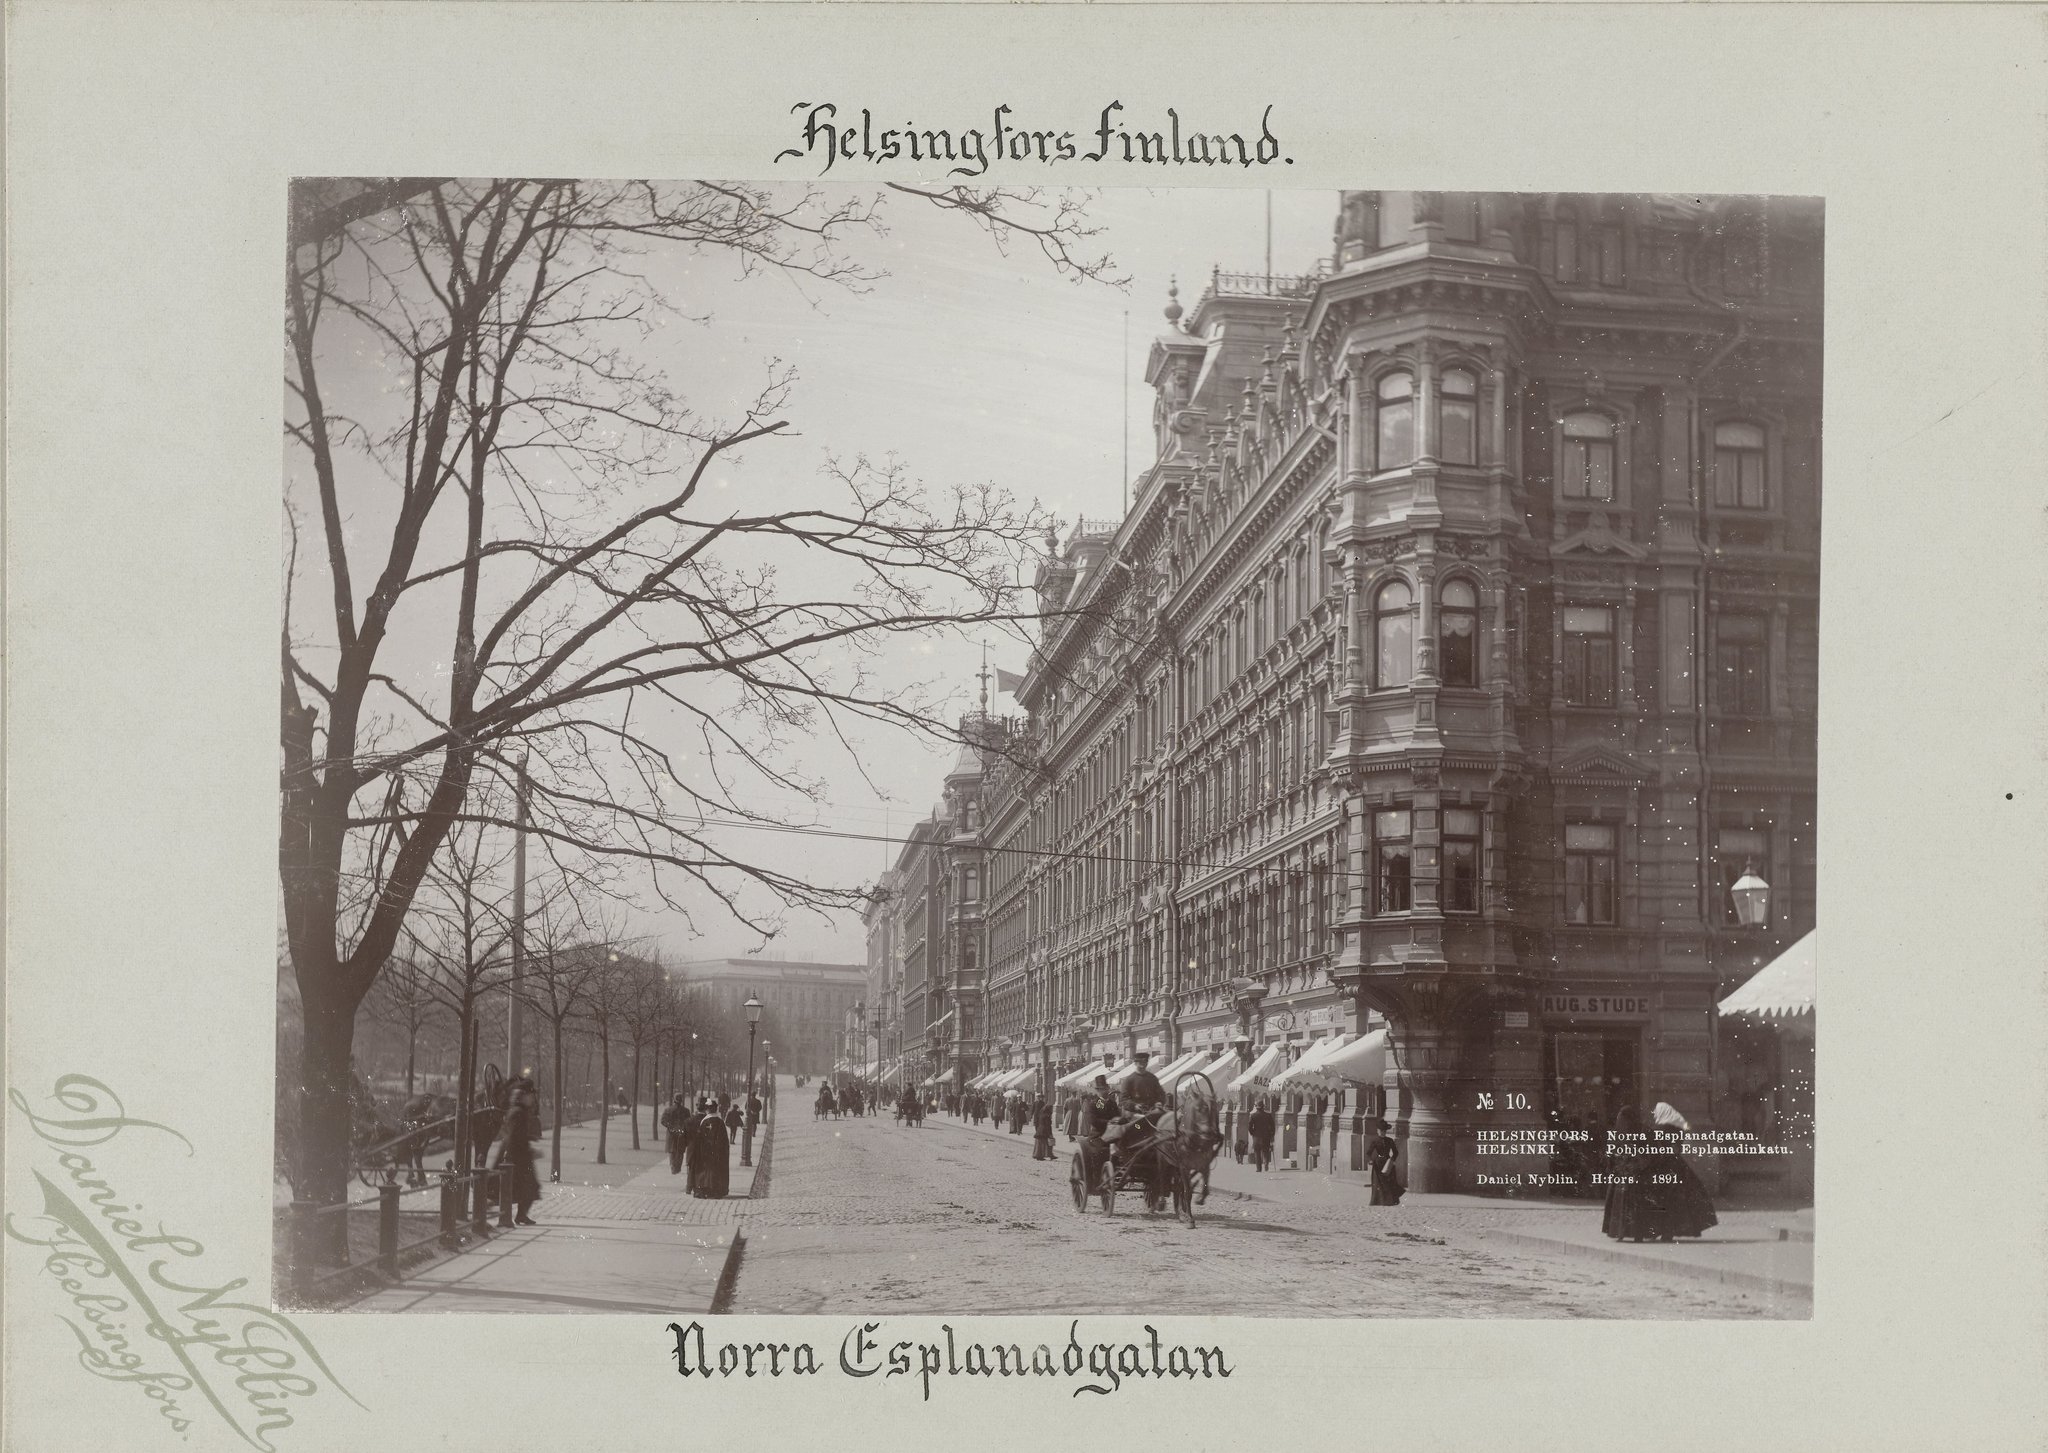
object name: photograph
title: Helsingfors Norra Esplanadgatan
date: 1898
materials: paper, photographic support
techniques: albumen print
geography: netherlands